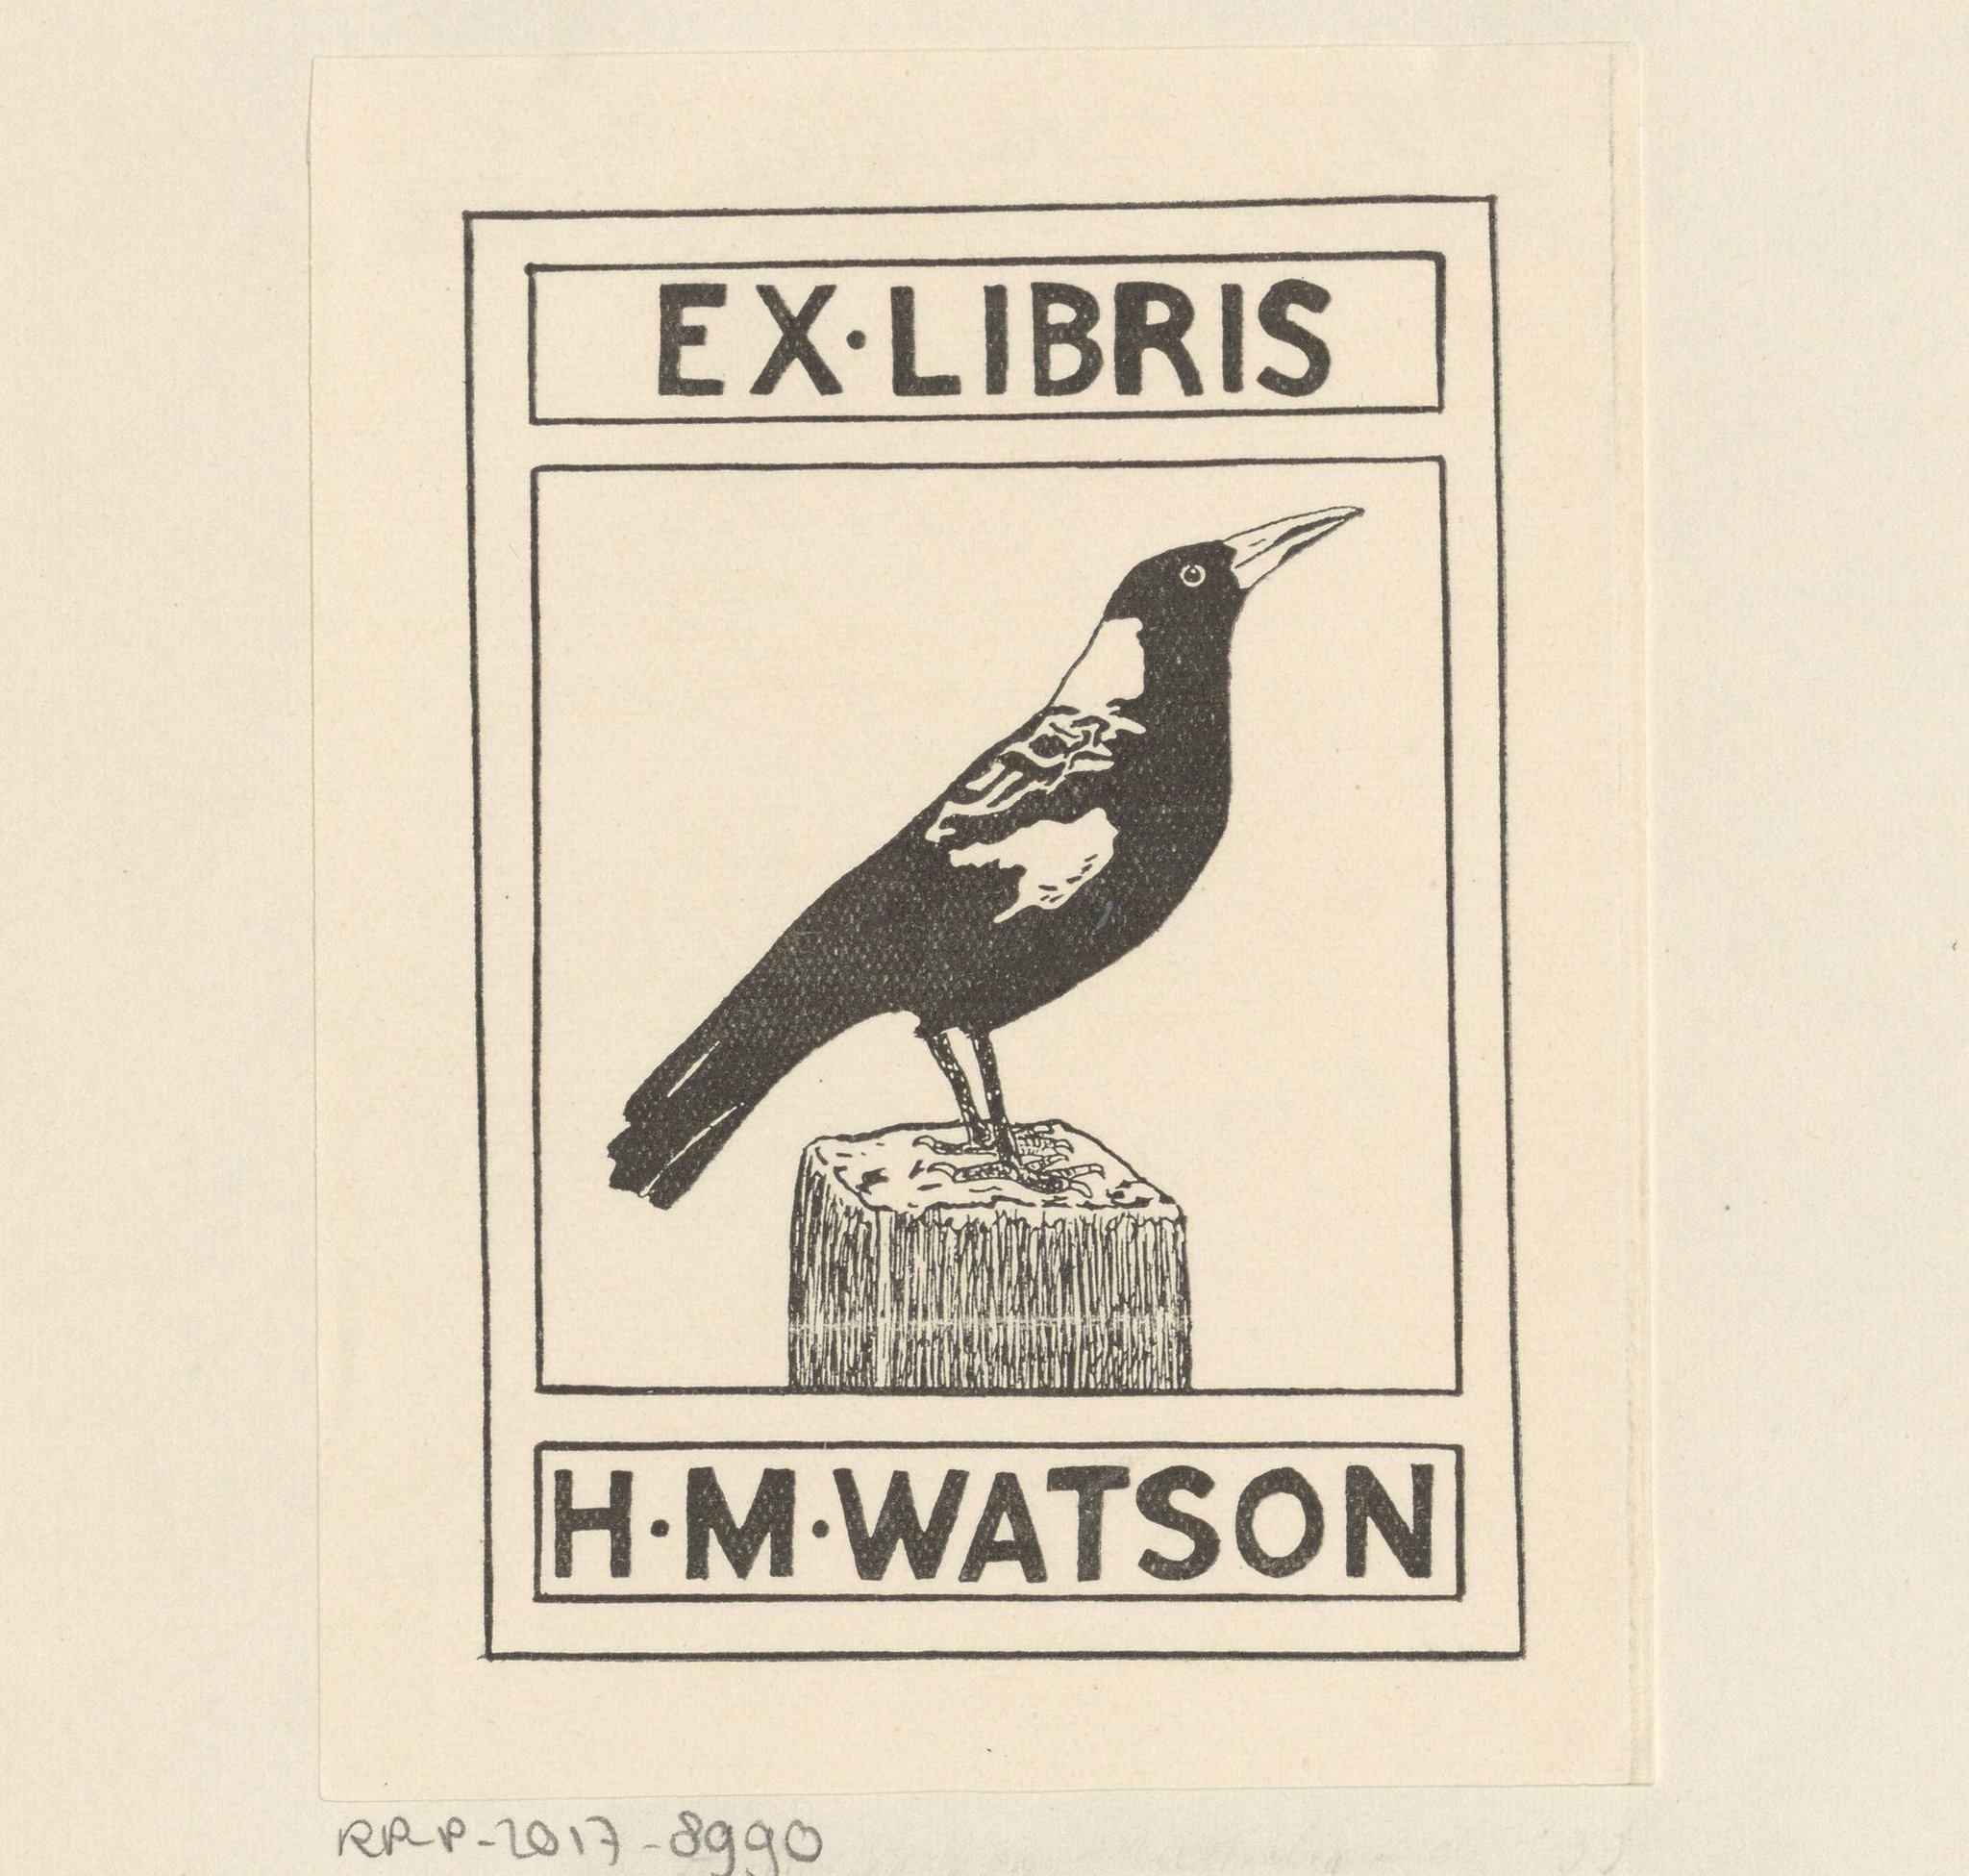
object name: bookplate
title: Ex libris van H.M. Watson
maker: Anonymous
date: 1933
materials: paper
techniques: printing block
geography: australia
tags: print maker, h.m. watson, song-birds: crow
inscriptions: inscription: ‘Design by/ H.M. Watson/ 1933’